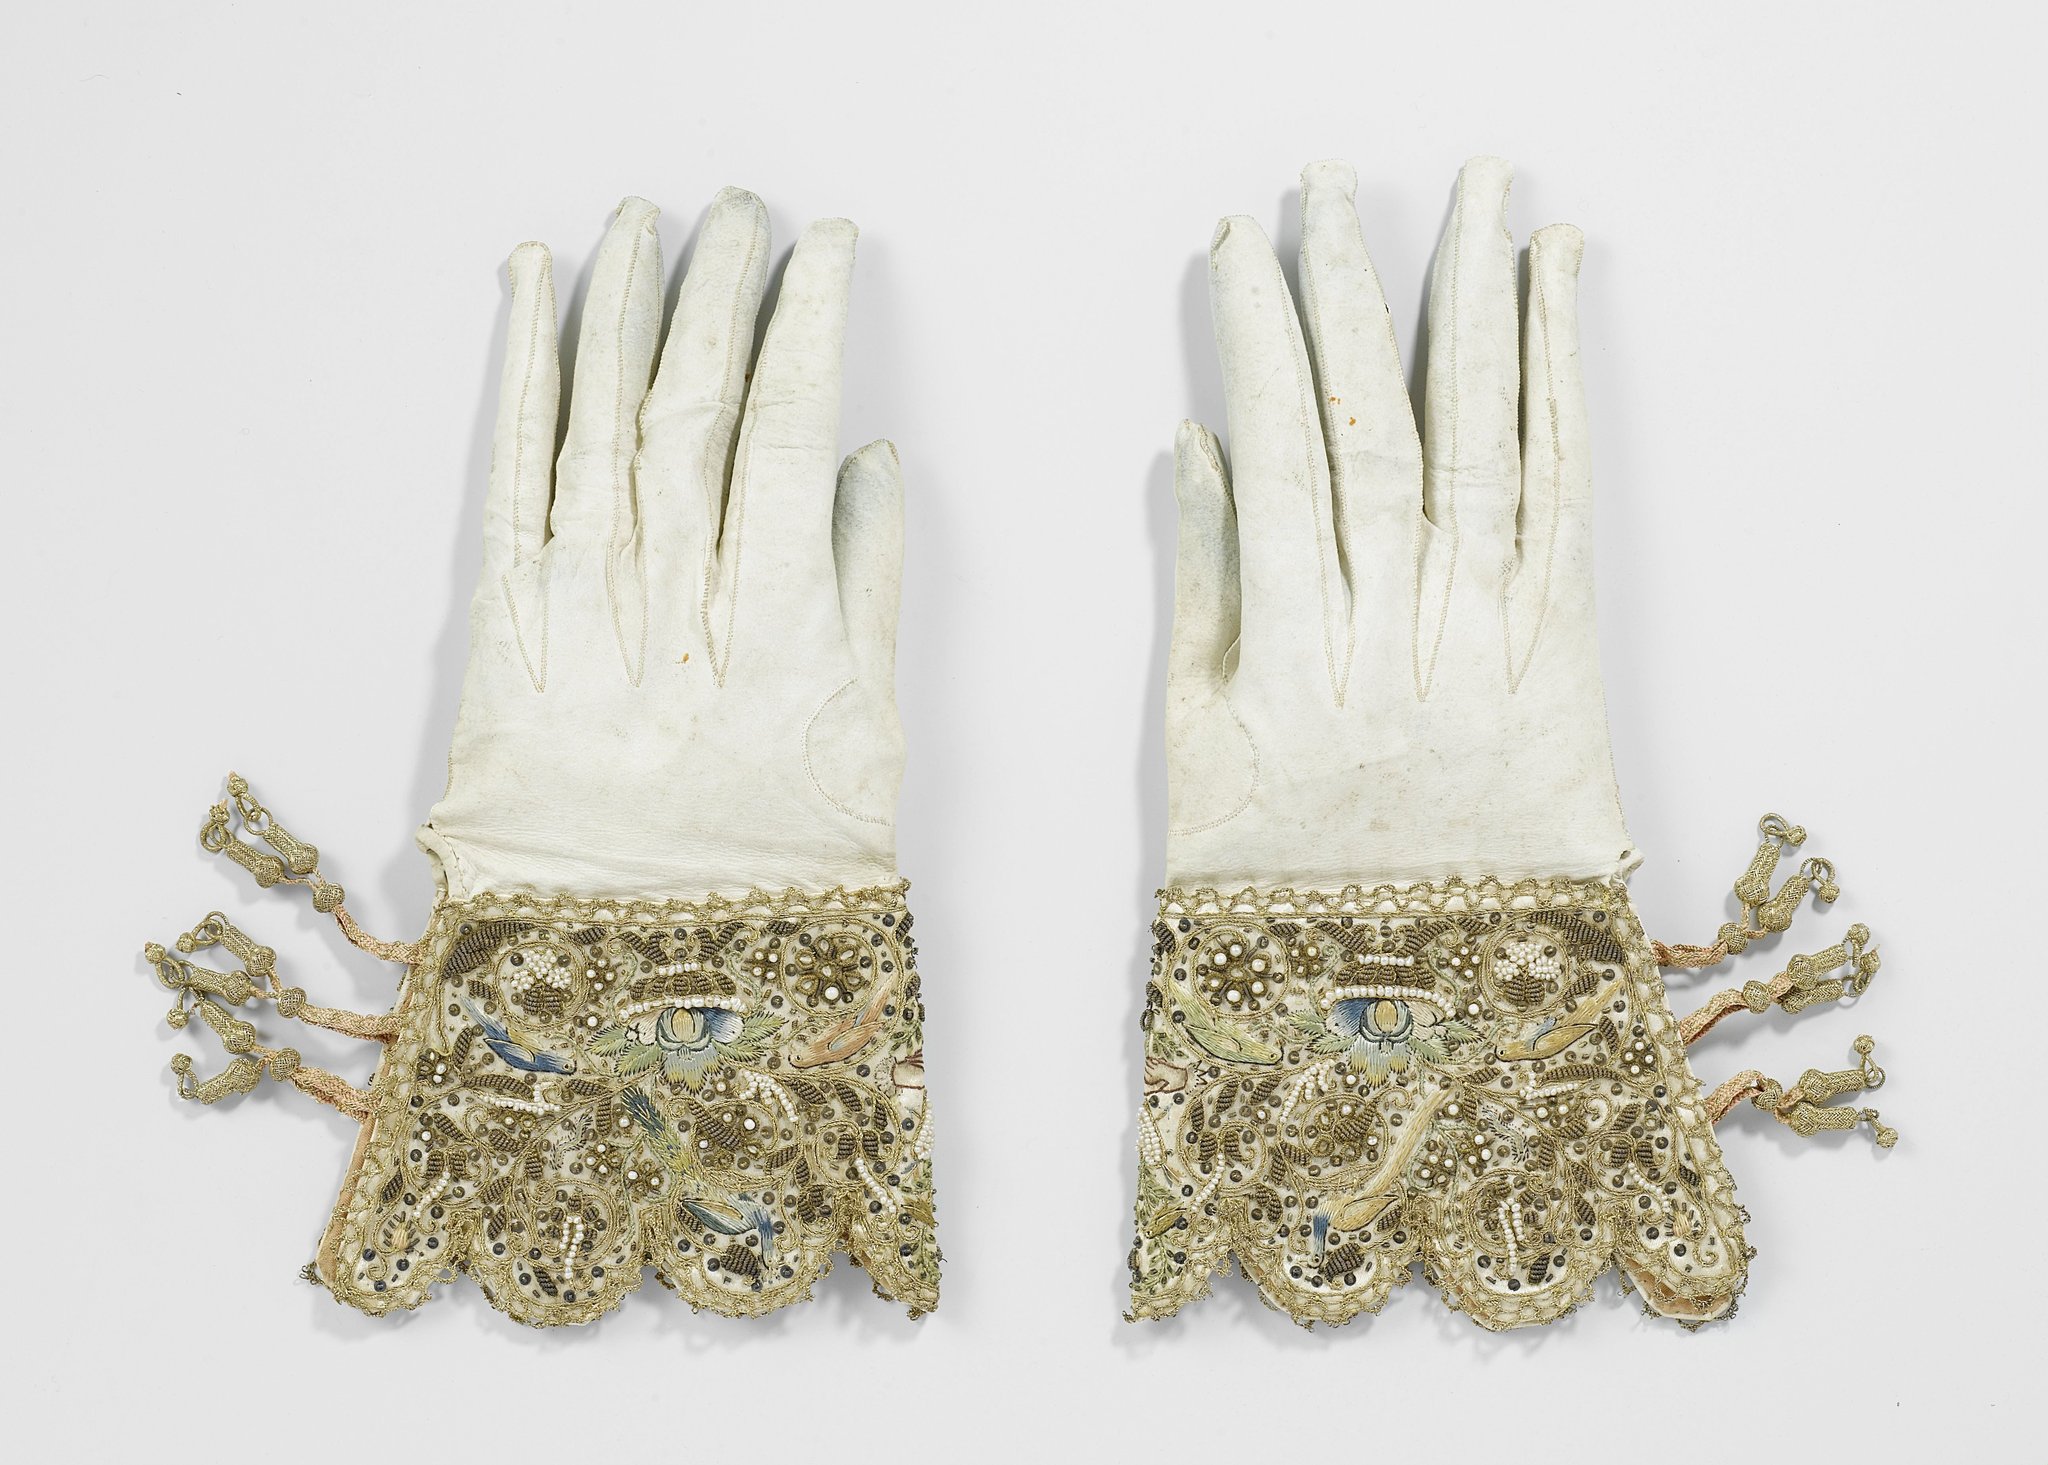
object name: glove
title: Glove of white waxed leather with silk and gold metal thread embroidery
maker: Anonymous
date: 1622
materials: leather, gold thread, silk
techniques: lace, embroidered, tanning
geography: netherlands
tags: pieter van son, johanna le maire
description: Linker bruidshandschoen van wit wasleer, rijk geborduurde kappen. Kappen met gelobde rand. Gesloten met drie paar rose veterbandjes, waarop een goudknopje geschoven wordt. Symmetrisch patroon van onder meer twee in elkaar gelegde handjes in bruin contour onder een met pijlen doorboord hart van pareltjes en twee toegewende vogeltjes. Rijk patroon in verschillende kleuren, borduurwerk, parels en pailletten. Rondom goudpassement van kloskant.